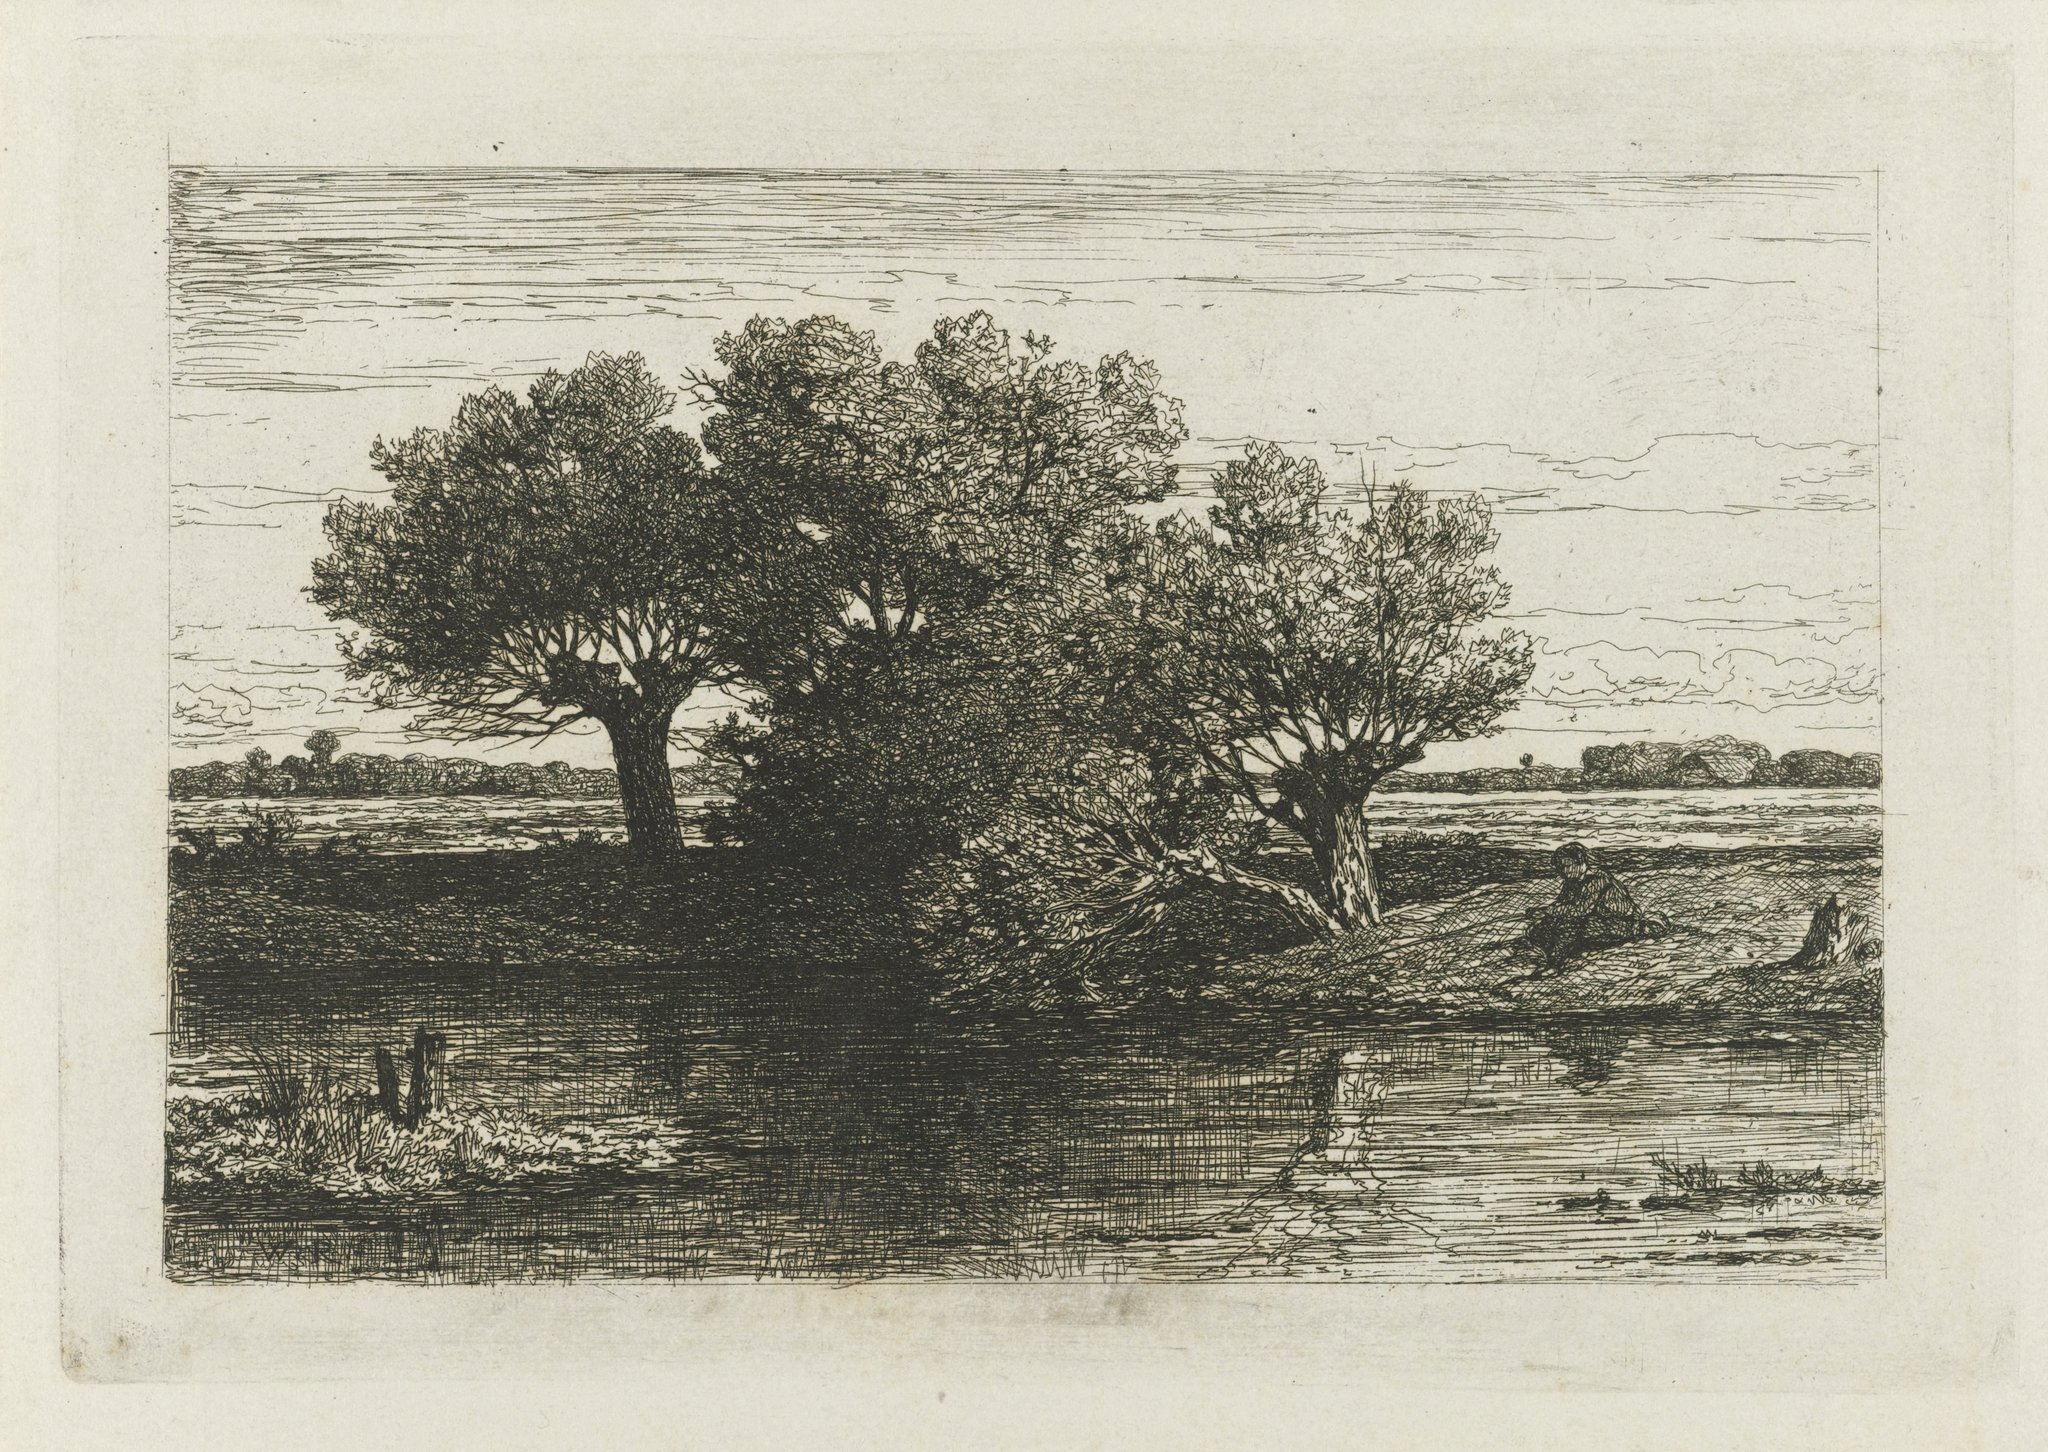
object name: print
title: Visser bij de knotwilgen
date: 1832-1897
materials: paper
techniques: drypoint, etching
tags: river, trees: willow, farm or solitary house in landscape, fisherman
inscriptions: collector's mark: Lugt 2228, collector's mark: Lugt 1485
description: Aan de rand van een riviertje zit een man te vissen. Naast hem enkele knotwilgen. Op de achtergrond de bosrand en een boerderij.